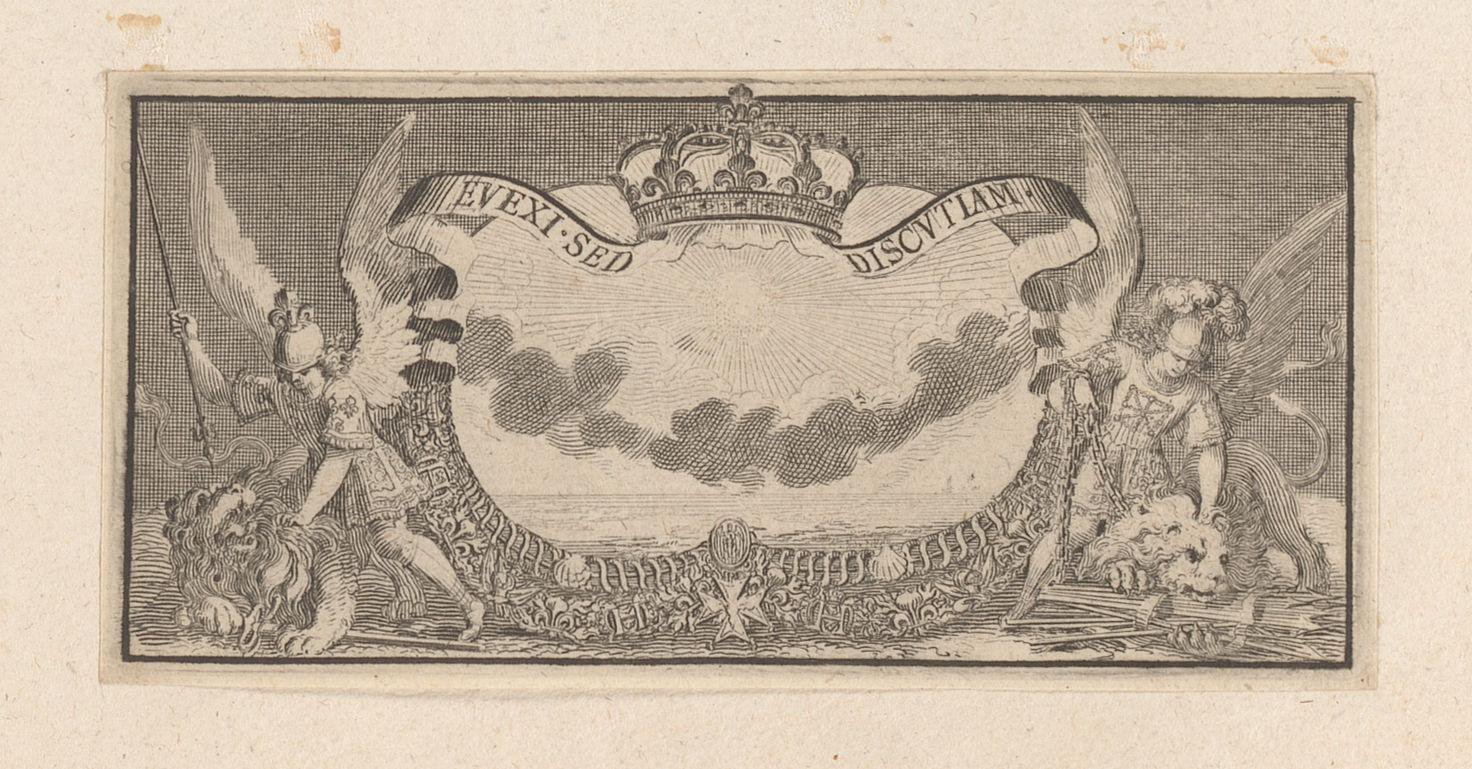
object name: print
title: Vignet met een allegorie op de oorlog tegen Nederland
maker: sébastien leclerc (i)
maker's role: print maker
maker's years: 1637-1714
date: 1672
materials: paper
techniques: etching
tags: personifications of countries, nations, states, districts, etc., vignette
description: Vignet ook gebruikt voor een pamflet ter voorbereiding op de Franse campagne tegen de Nederlanden. Voor dit pamflet zie British Museum, inv.nr. 1871,1209.4829.